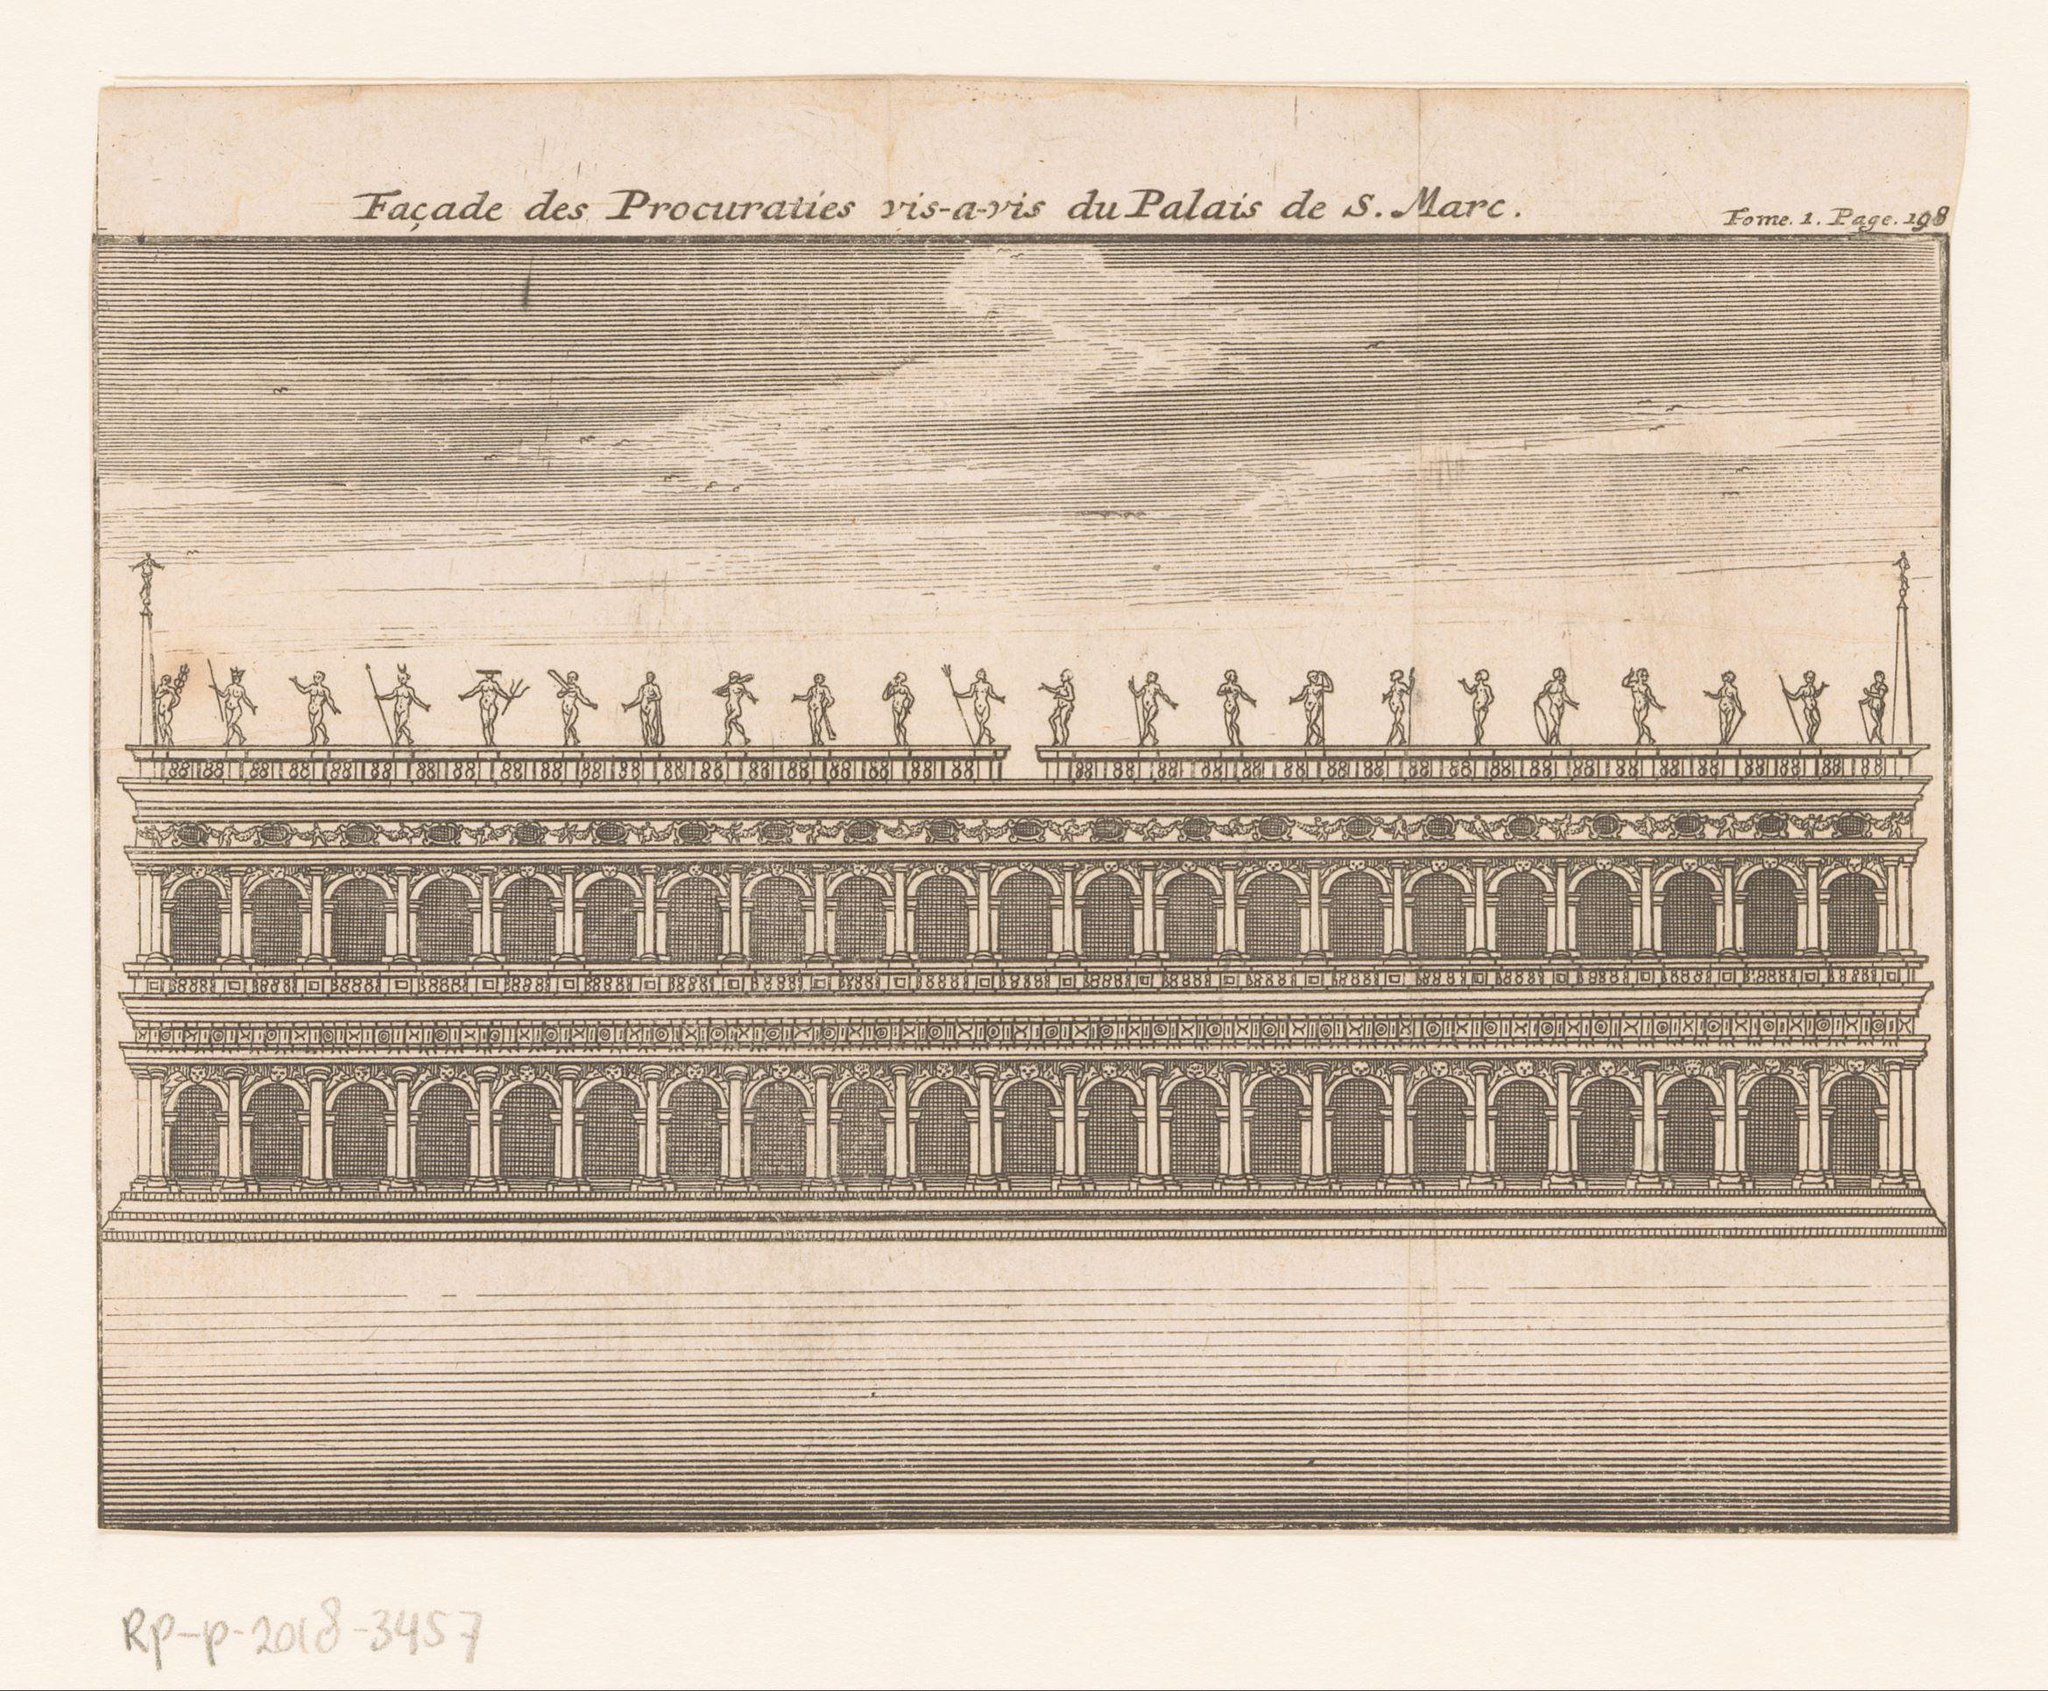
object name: print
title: Gezicht op de Biblioteca Marciana op het San Marcoplein te Venetië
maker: Anonymous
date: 1670-1750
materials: paper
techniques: etching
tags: exterior ~ representation of a building, civic architecture; edifices; dwellings, public library